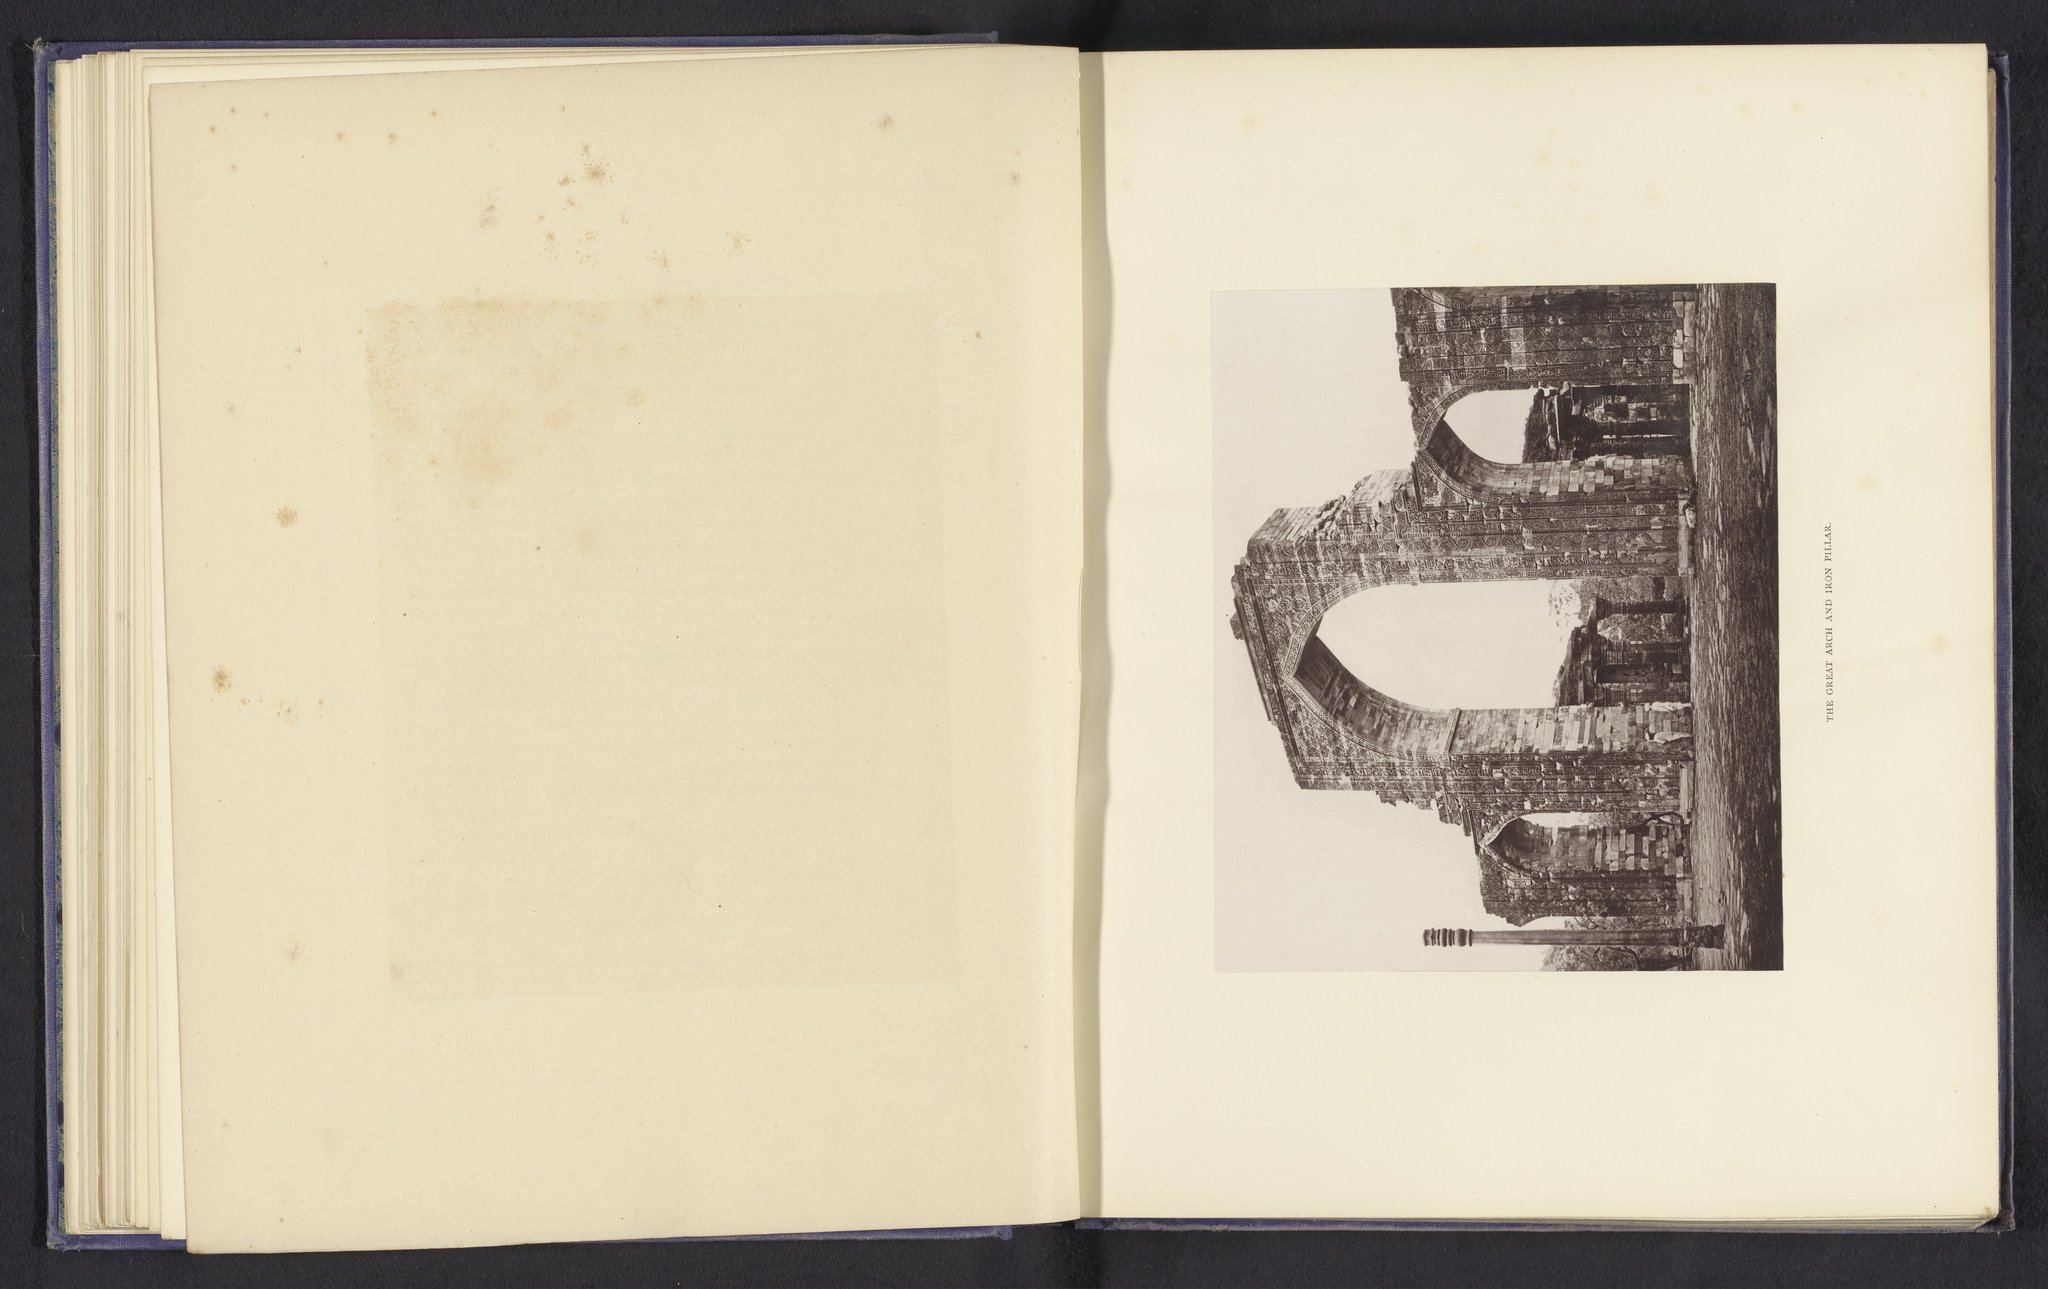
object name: page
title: Gezicht op een poort en en pilaar bij het Qutb complex in Delhi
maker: Anonymous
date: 1860-1877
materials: paper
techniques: woodburytype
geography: delhi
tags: column, pillar ~ architecture, arch, archivolt ~ architecture